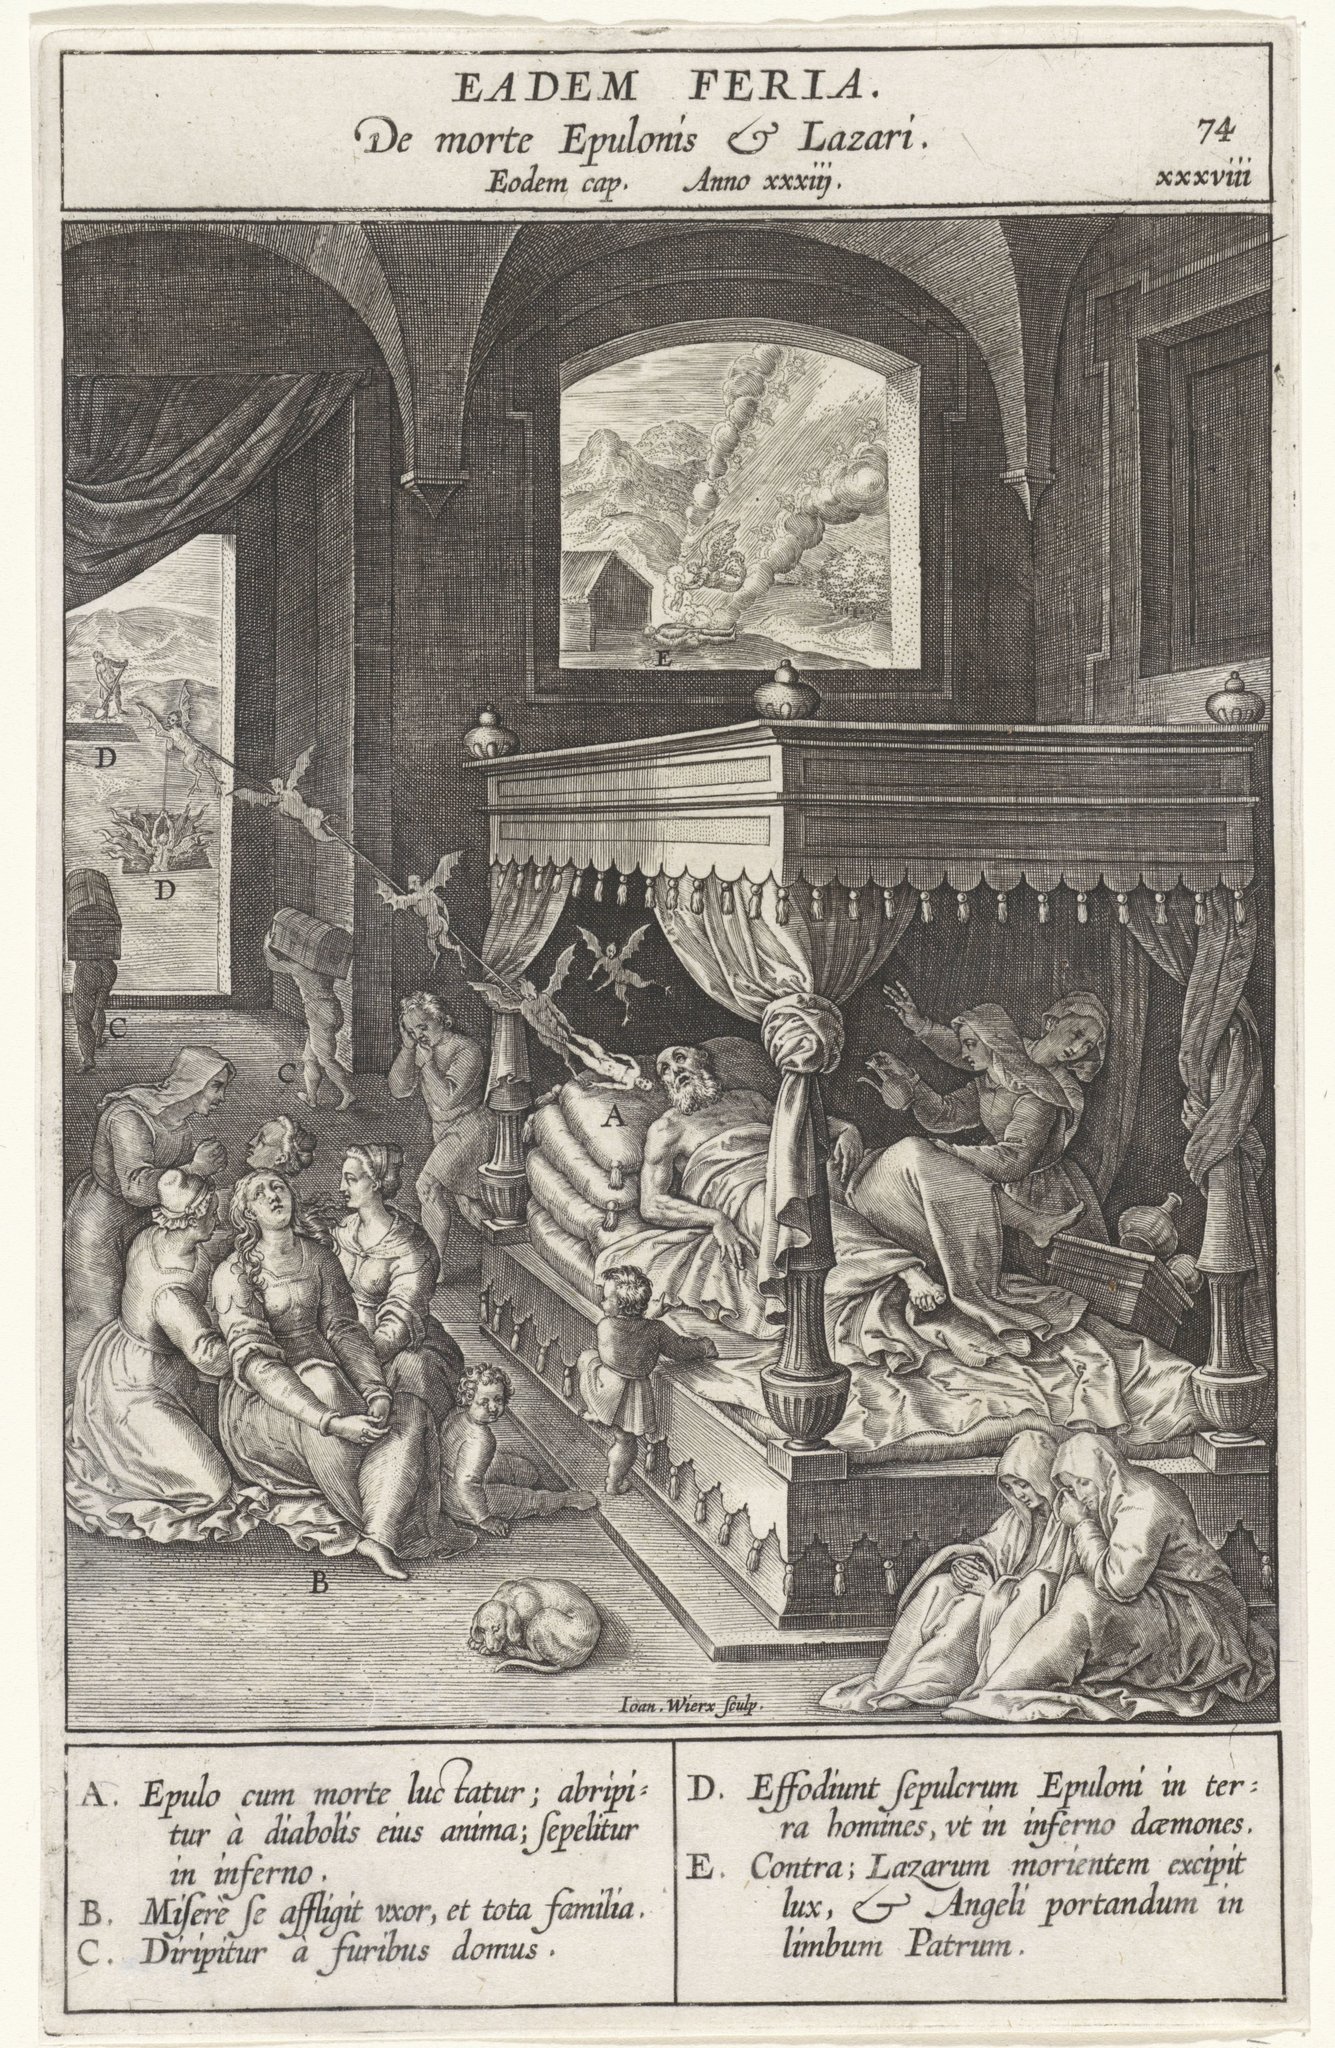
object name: print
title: De dood van de rijke man en van Lazarus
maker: johannes wierix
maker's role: draughtsman, print maker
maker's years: 1549-1618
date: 1593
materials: paper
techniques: engraving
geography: antwerp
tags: lazarus dies: his soul is carried into abraham's lap by angels, dives dies; his soul is brought into hell by devils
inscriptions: collector's mark: Lugt 2165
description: De rijke man ligt op zijn sterfbed. Familie en vrienden treuren om de dode. Duivels nemen de ziel van de rijke man mee naar de hel. Op de achtergrond is te zien hoe de ziel van Lazarus door een engel naar de hemel wordt meegenomen. Bij verschillende elementen uit de voorstelling staan letters die corresponderen met de legenda in de marge.